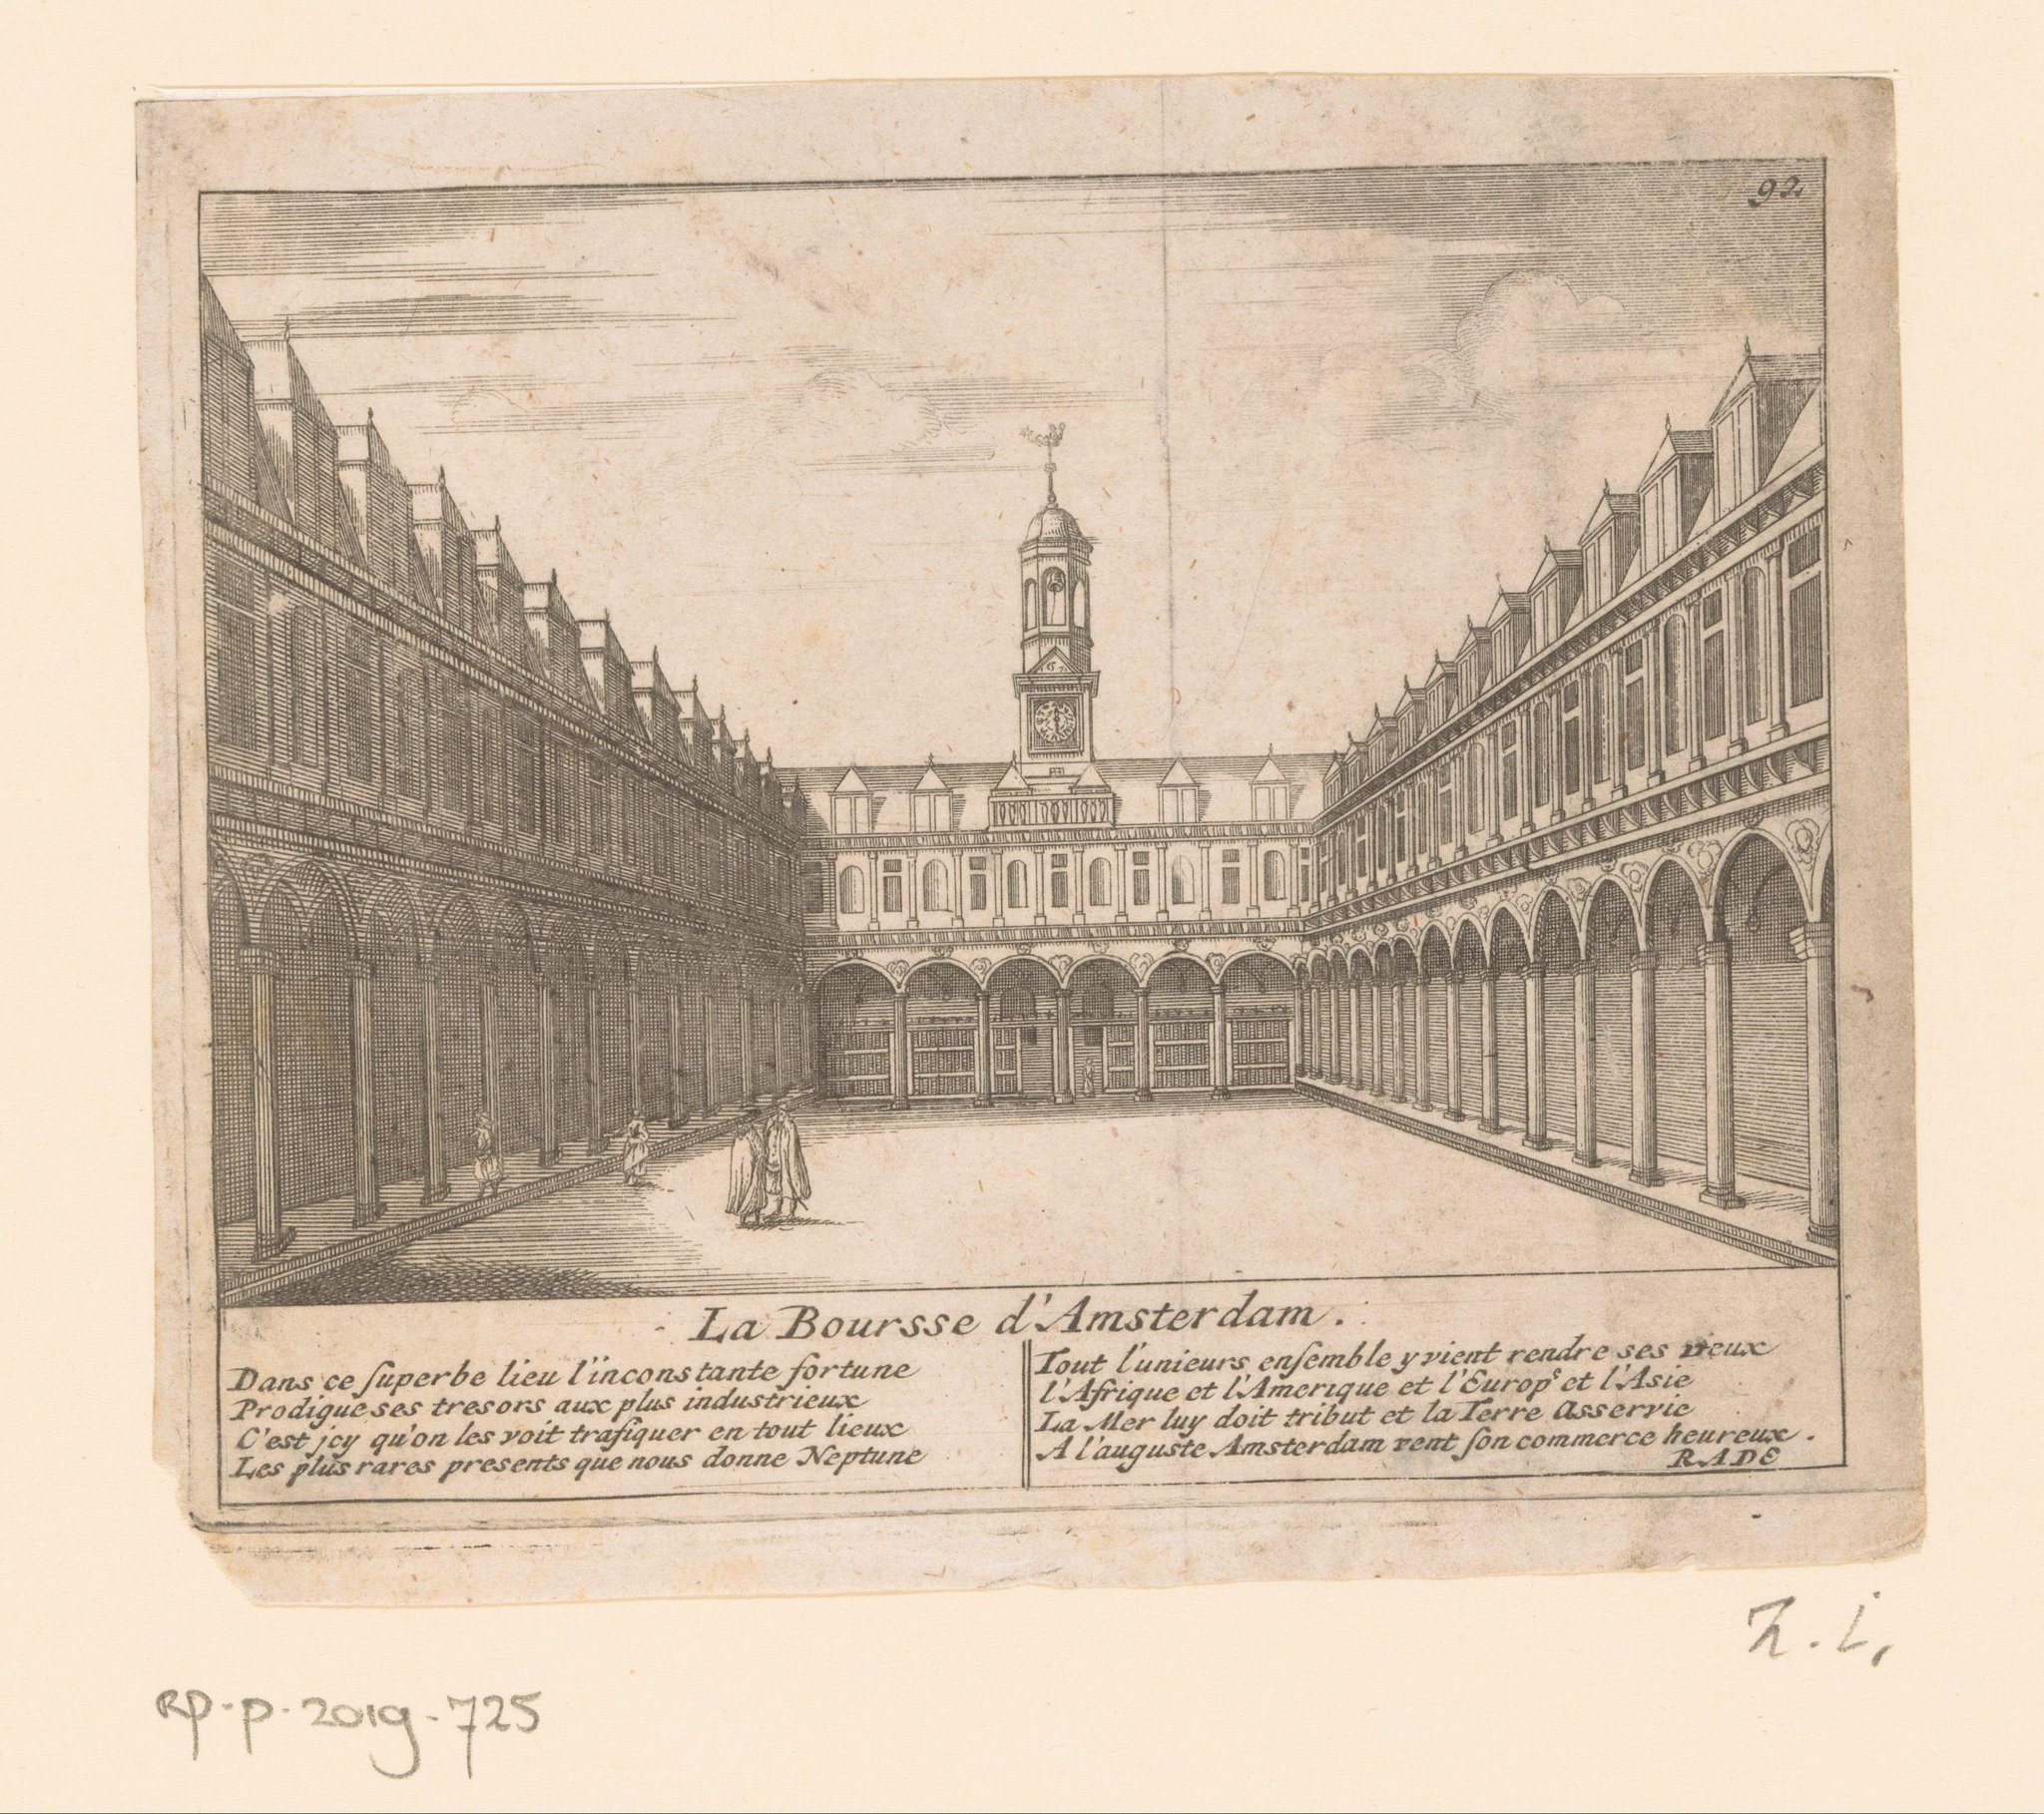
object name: print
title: La Boursse d'Amsterdam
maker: Anonymous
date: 1610-1750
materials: paper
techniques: engraving, etching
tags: tower, clock tower ~ monumental adornment, stock exchange, stock-market